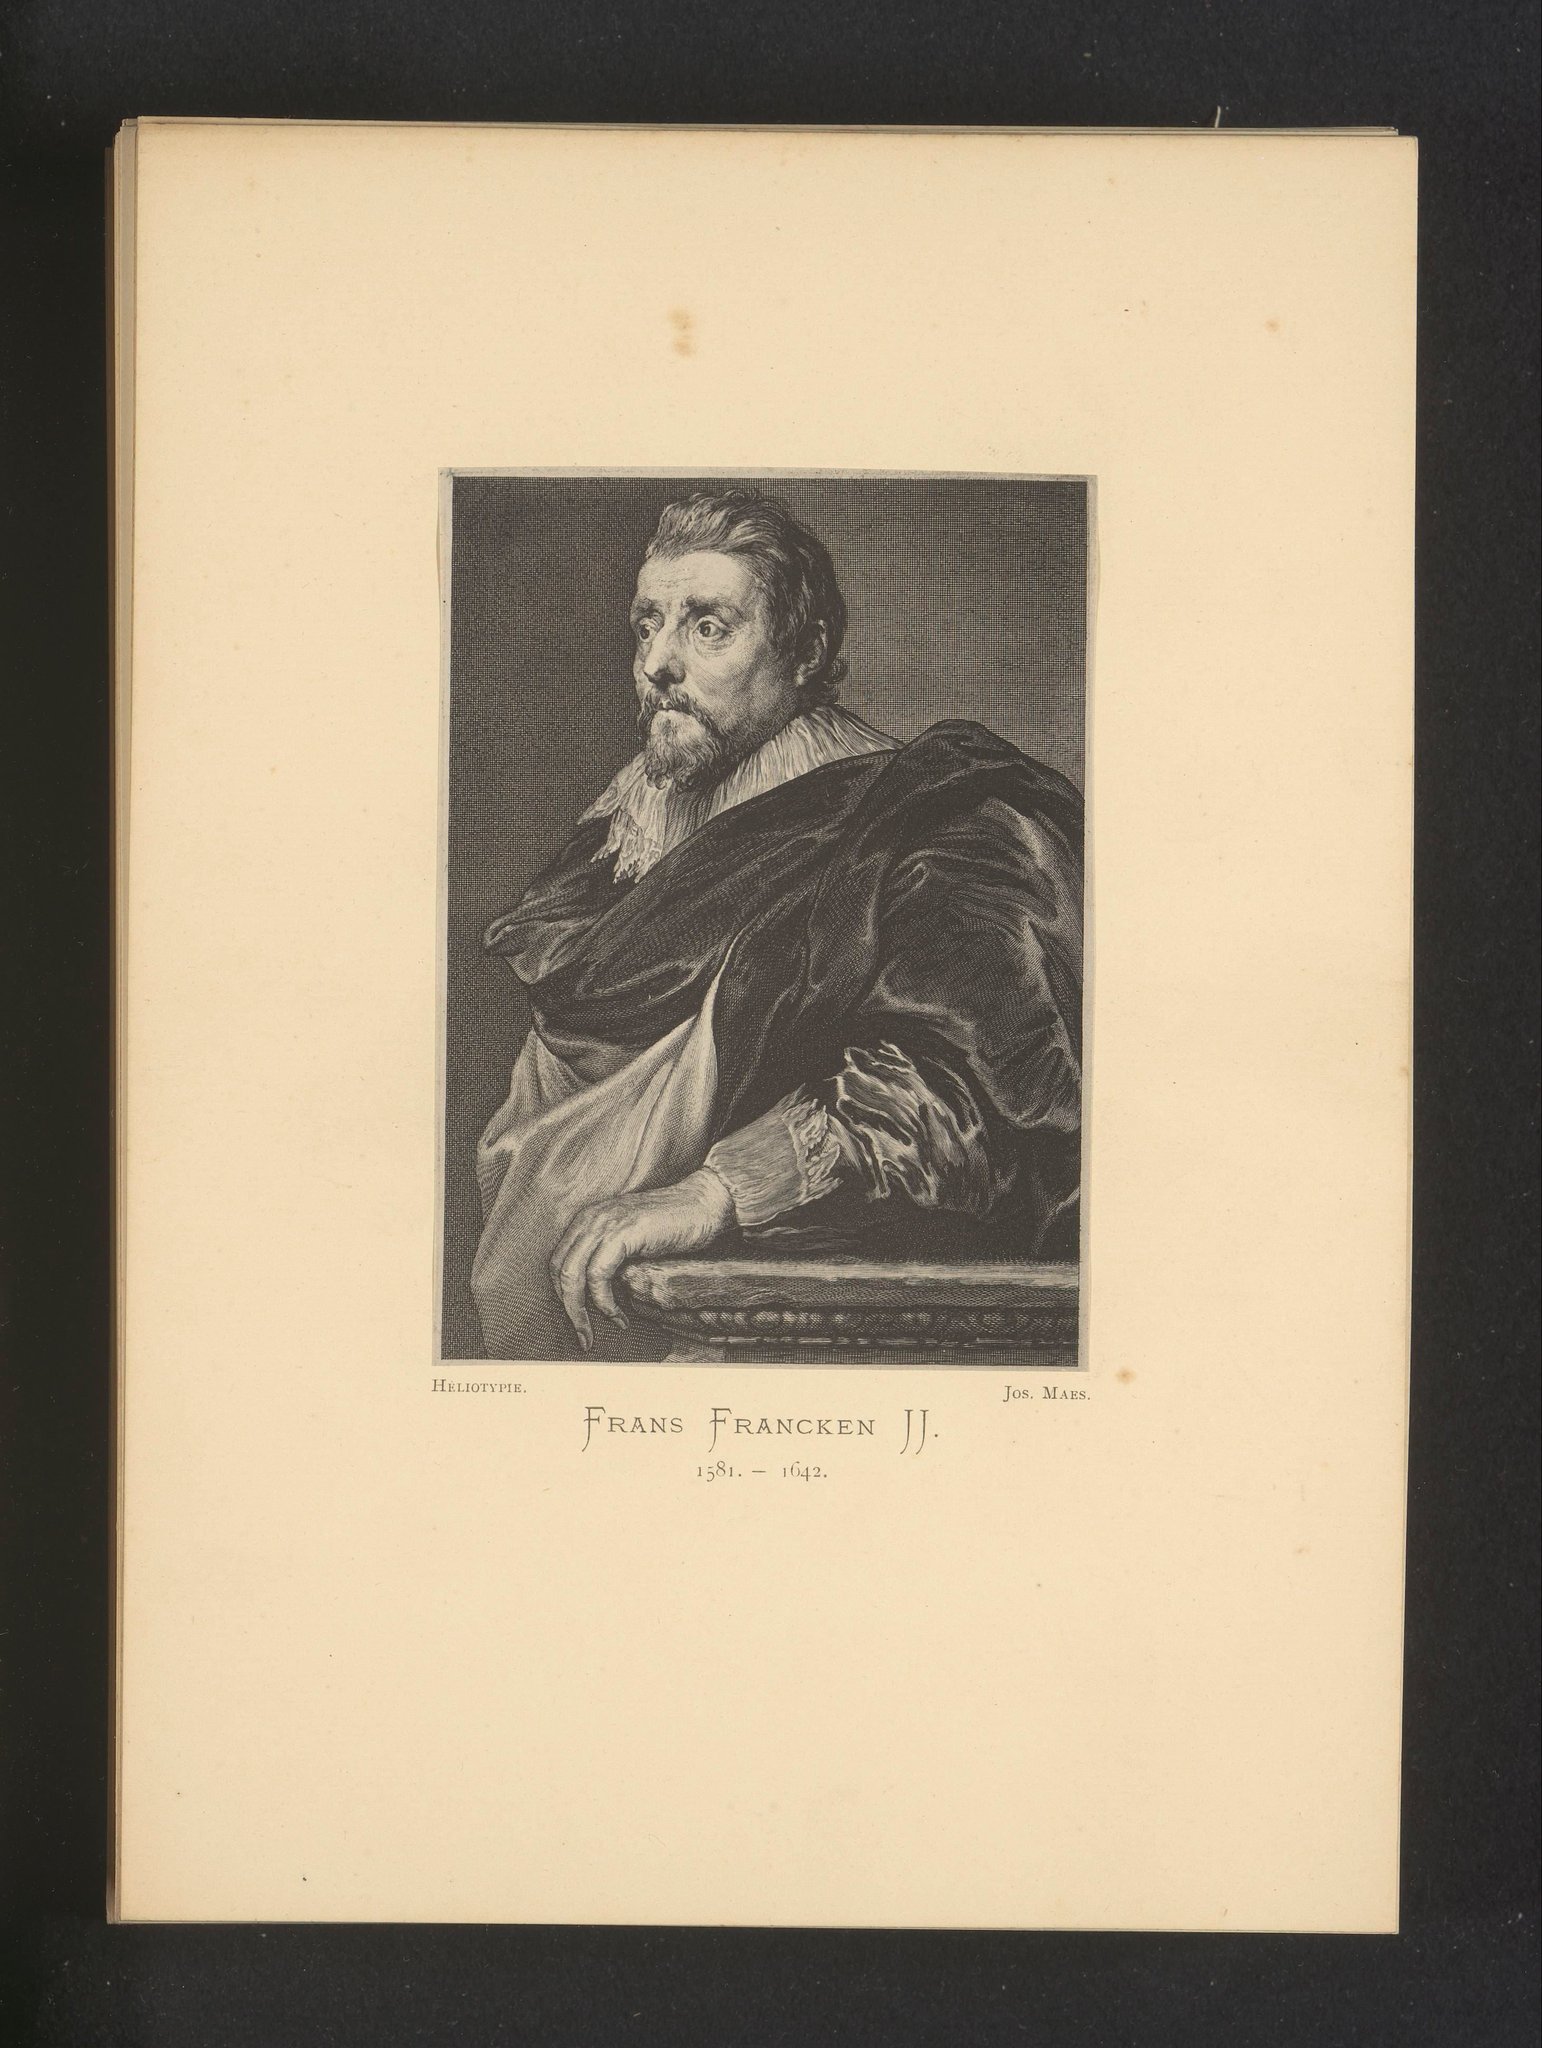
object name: reproduction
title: Frans Francken JJ.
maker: joseph maes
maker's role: fotograaf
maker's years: 1838-1908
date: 1872-1877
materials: cardboard, paper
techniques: photograph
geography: antwerp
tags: antwerp, draughtsman, frans francken (ii), historical persons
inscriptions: inscription: ‘1581. - 1642.’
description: Deze prent maakt deel uit van een omslag met 150 prenten en een katern met een lijst van afbeeldingen.